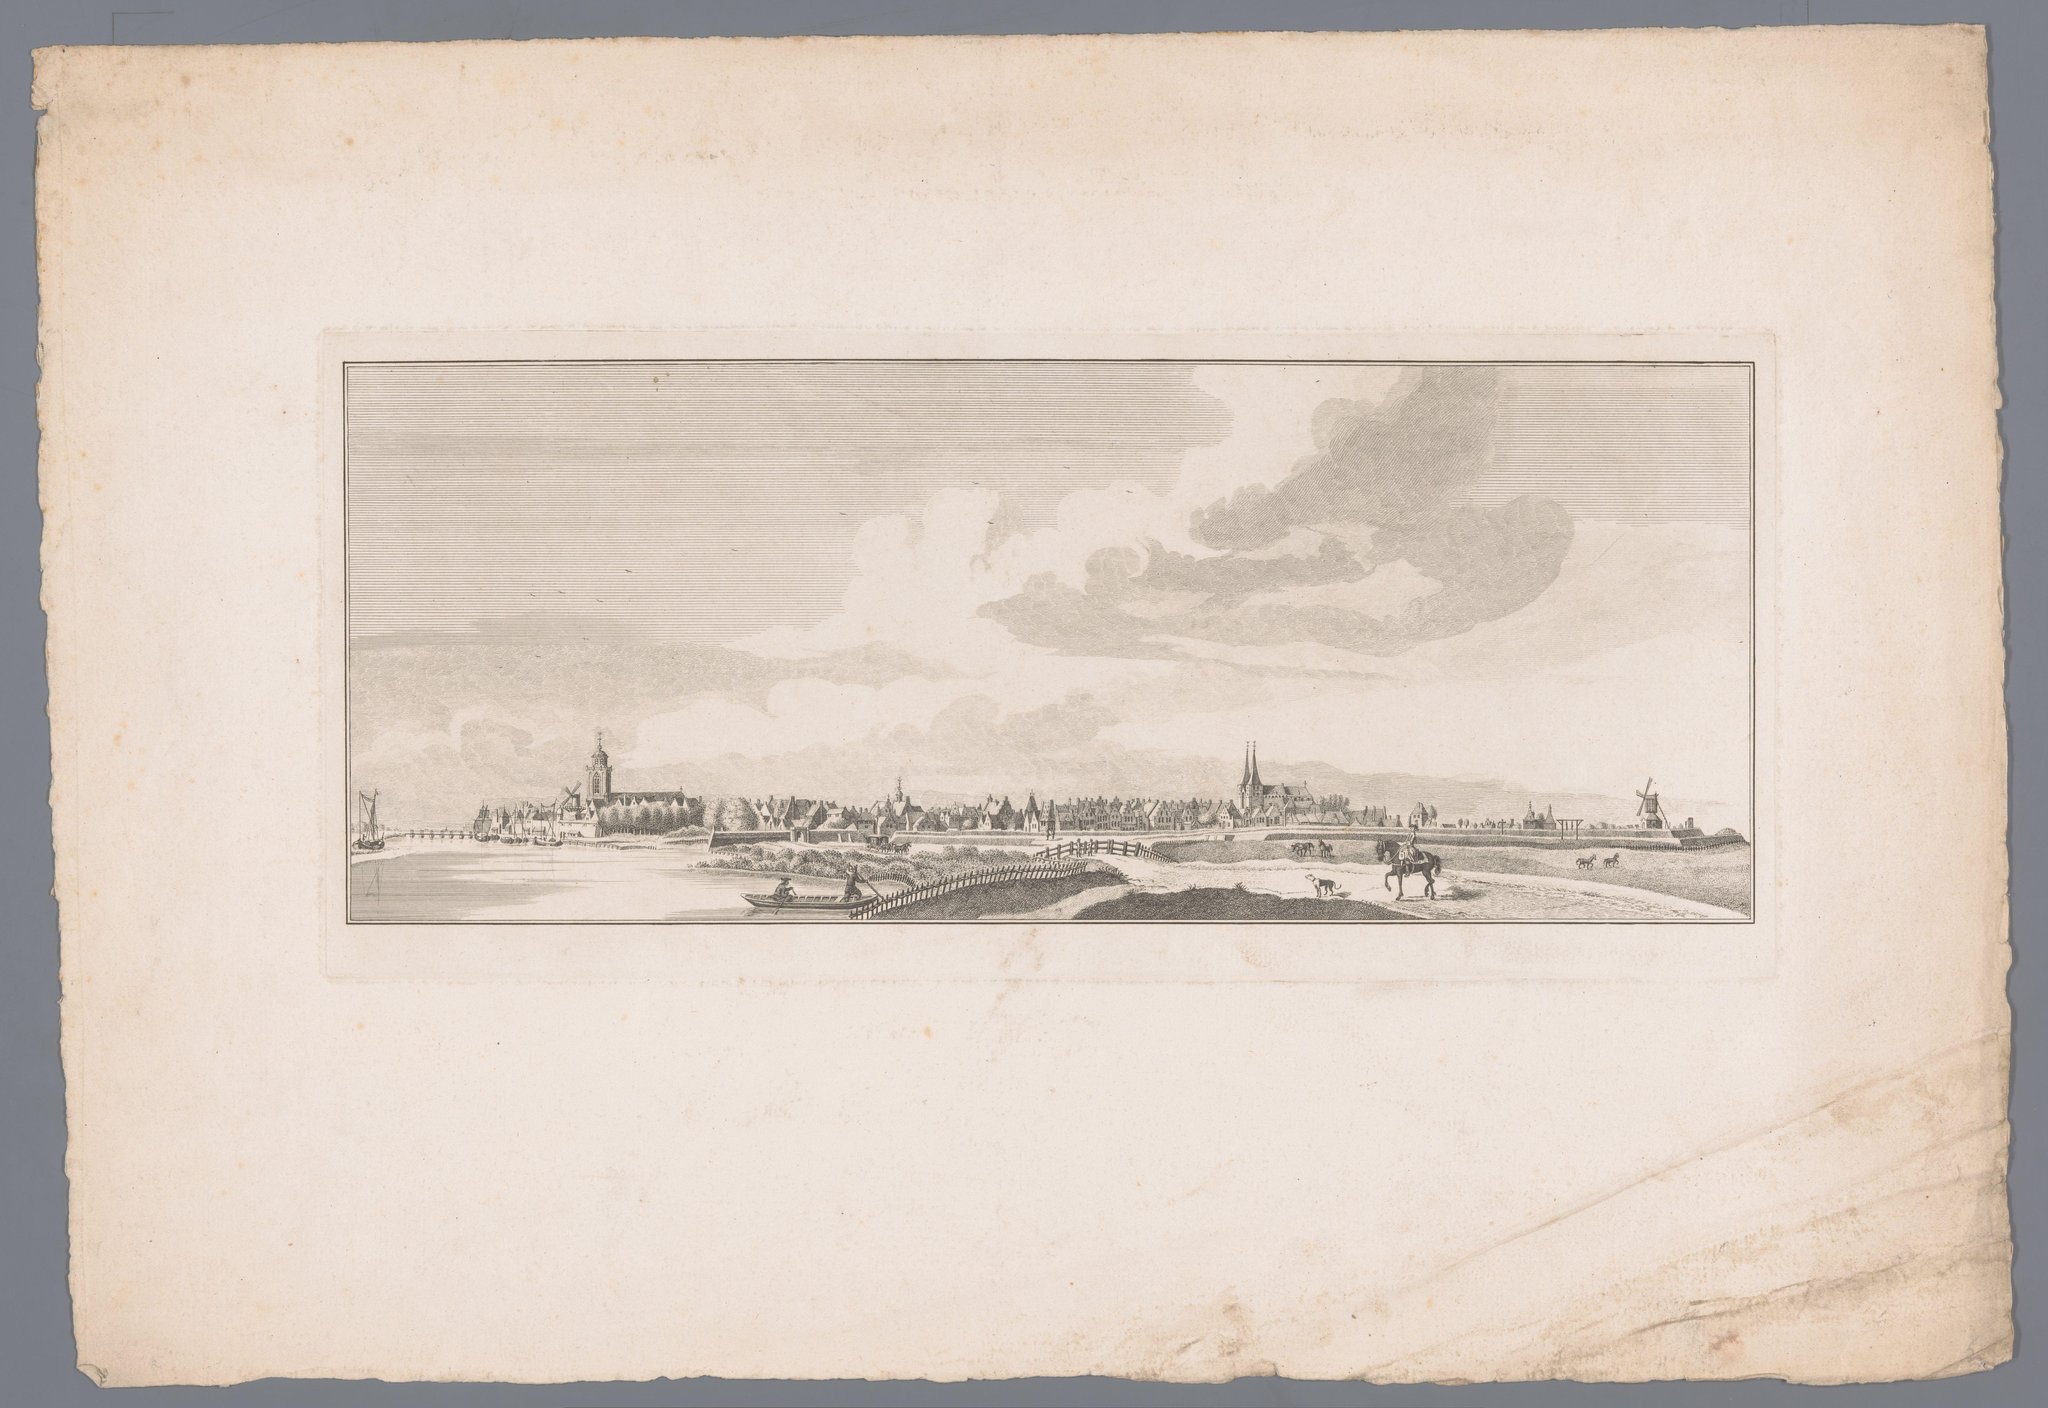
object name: print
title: Gezicht op Deventer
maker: Anonymous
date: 1770-1830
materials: paper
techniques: etching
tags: river, prospect of city, town panorama, silhouette of city (+ city(-scape) with figures, staffage), deventer